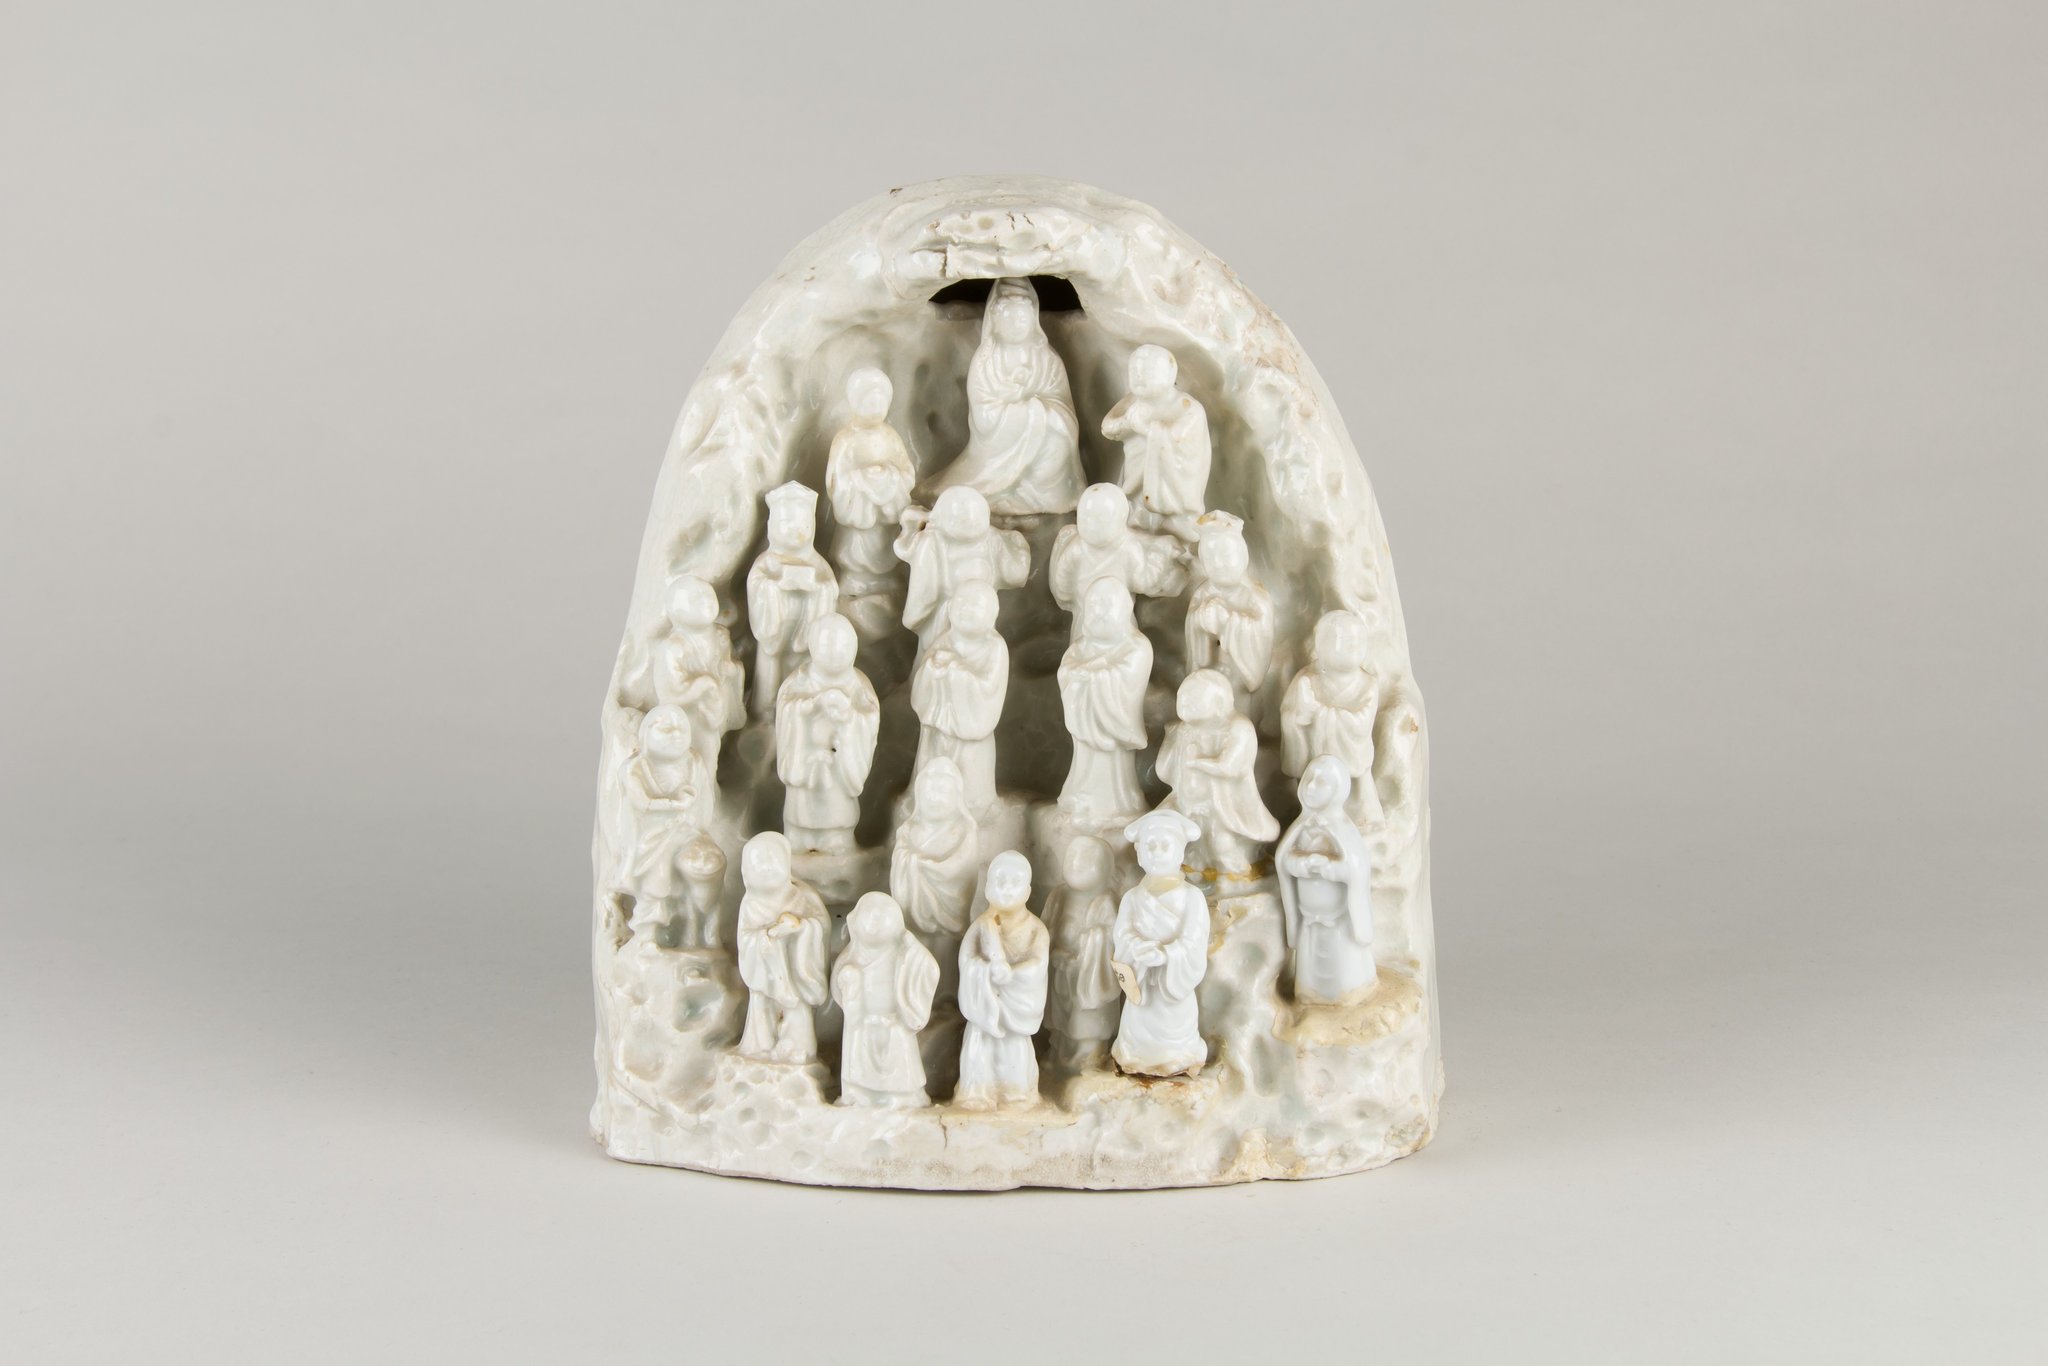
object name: ceramic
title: Grotto with Guanyin and Twenty Disciples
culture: chinese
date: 1701-1800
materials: porcelain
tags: buddhism,bodhisattvas